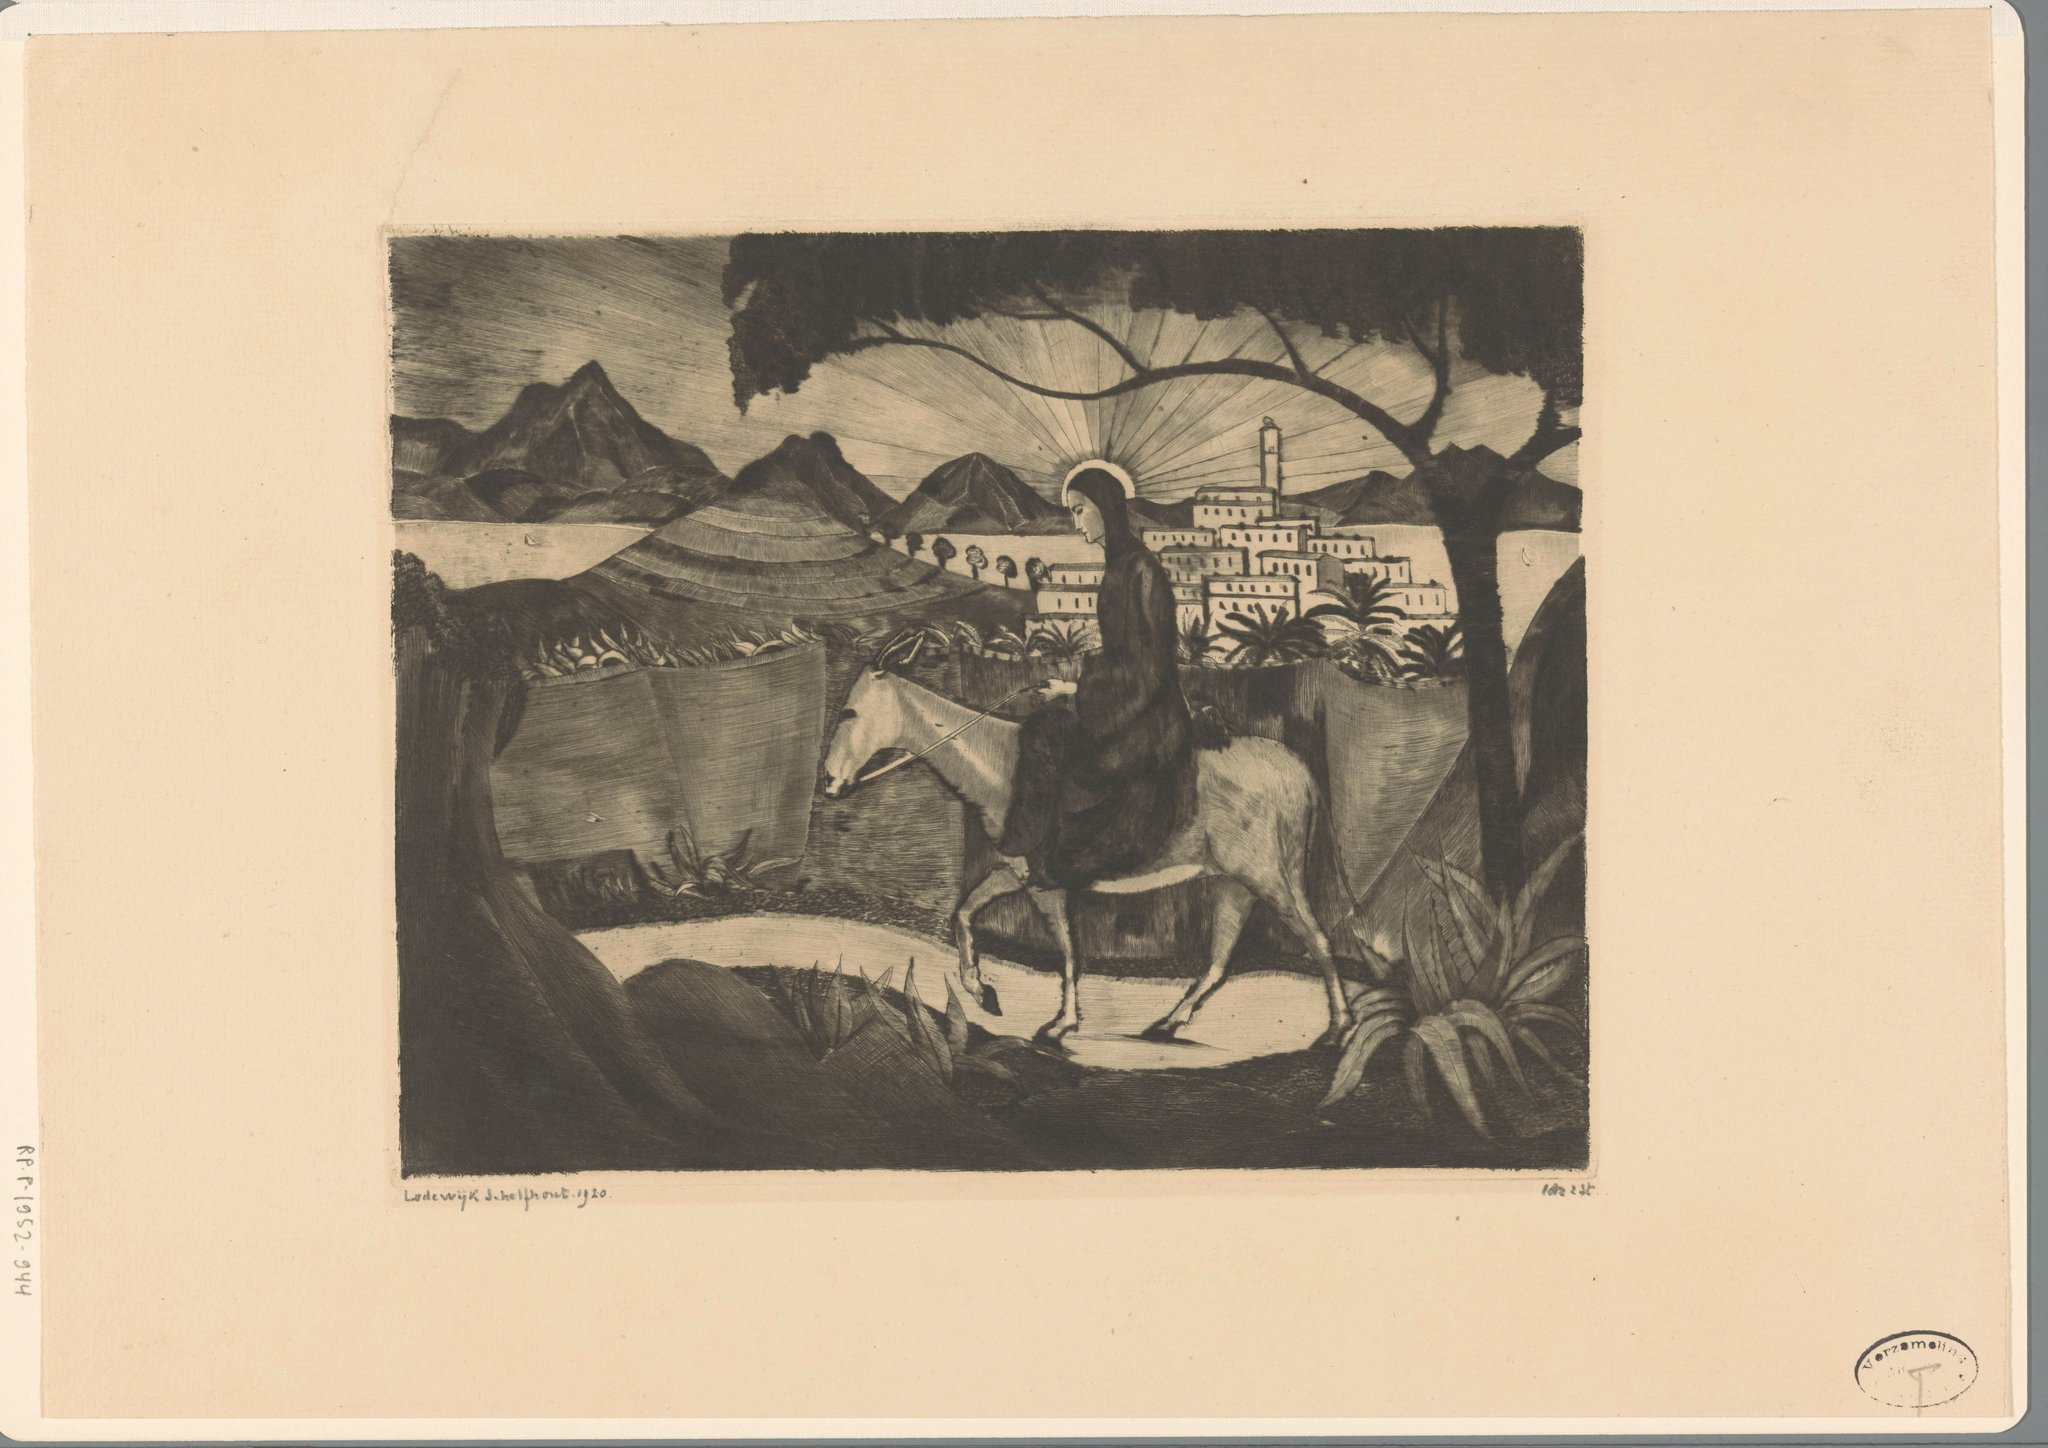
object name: print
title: Corsicaanse vrouw op een ezel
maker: lodewijk schelfhout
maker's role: draughtsman, print maker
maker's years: 1881-1943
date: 1920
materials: paper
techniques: drypoint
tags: ass, donkey, mountains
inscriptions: collector's mark: Lugt 5i, collector's mark: Lugt 2760, collector's mark: Lugt 2228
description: Een Corsicaanse vrouw rijdt op een ezel over een pad in een berglandschap. Op de achtergrond bergen en een nederzetting aan een baai. Achter het hoofd van de vrouw schijnt de zon.